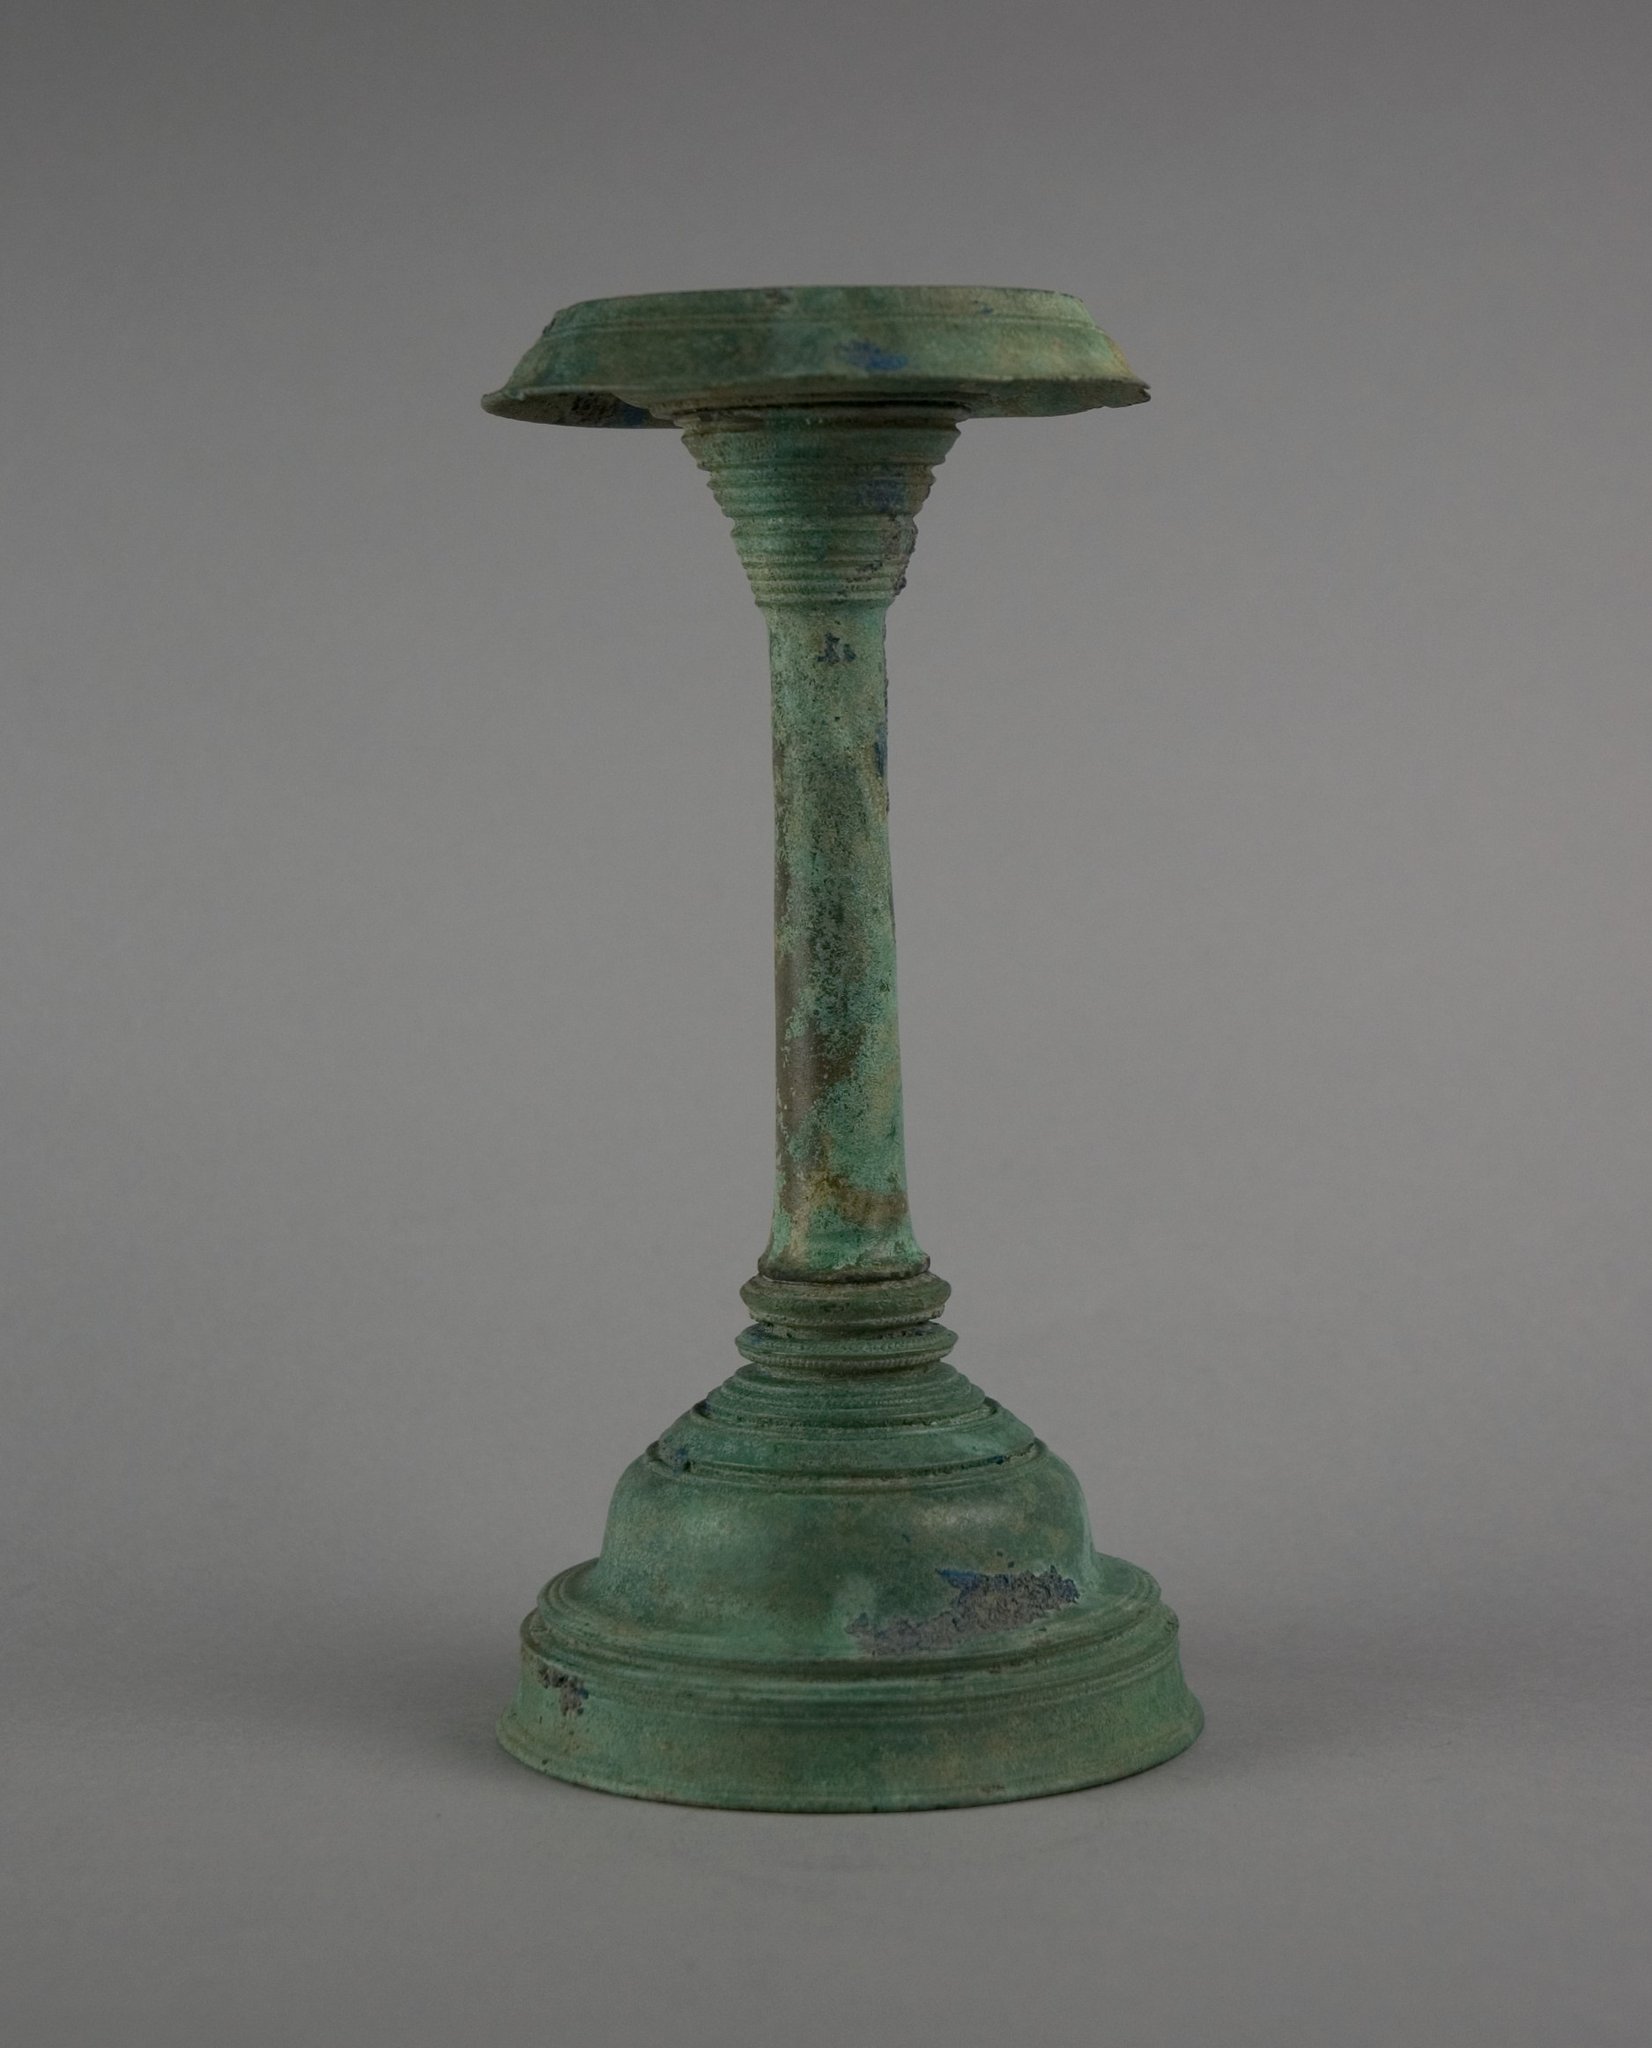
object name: oil lamp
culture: thai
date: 1301-1400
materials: bronze